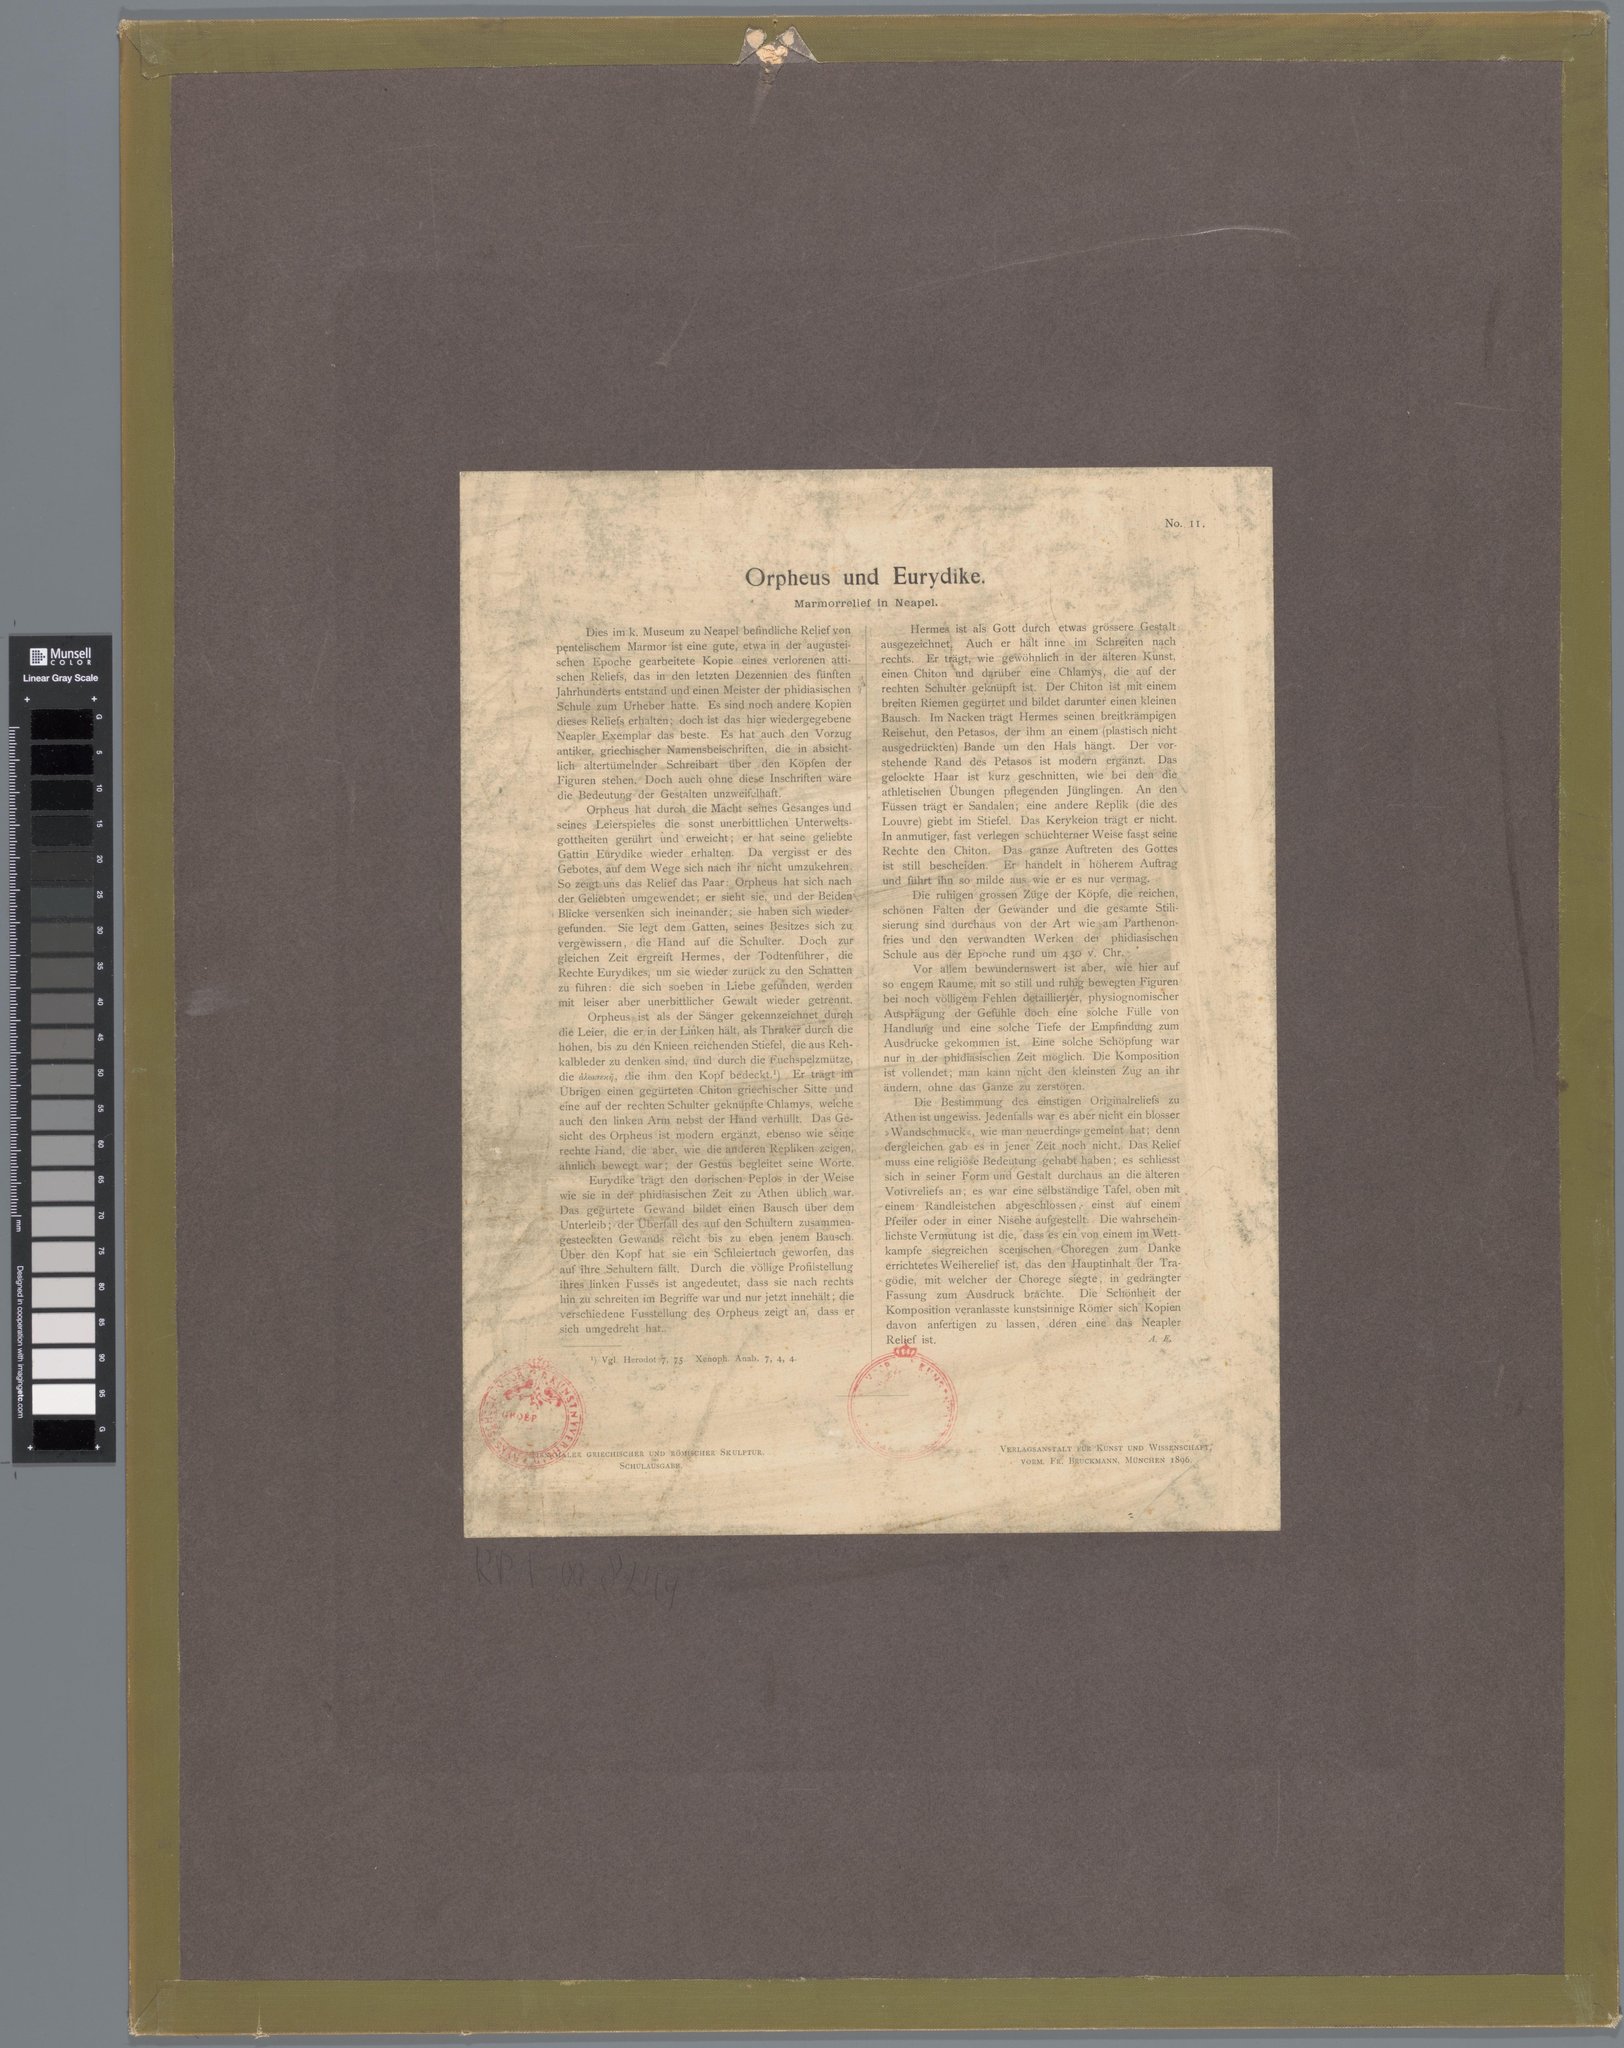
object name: photograph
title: Orpheus und Eurydike.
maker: Anonymous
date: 1896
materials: cardboard, paper, ink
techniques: photograph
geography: munich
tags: (story of) mercury (hermes), orpheus and eurydice, sculpture (+ relief ~ sculpture)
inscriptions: inscription:, number: ‘No. 11.’, collector's mark: Lugt 3937